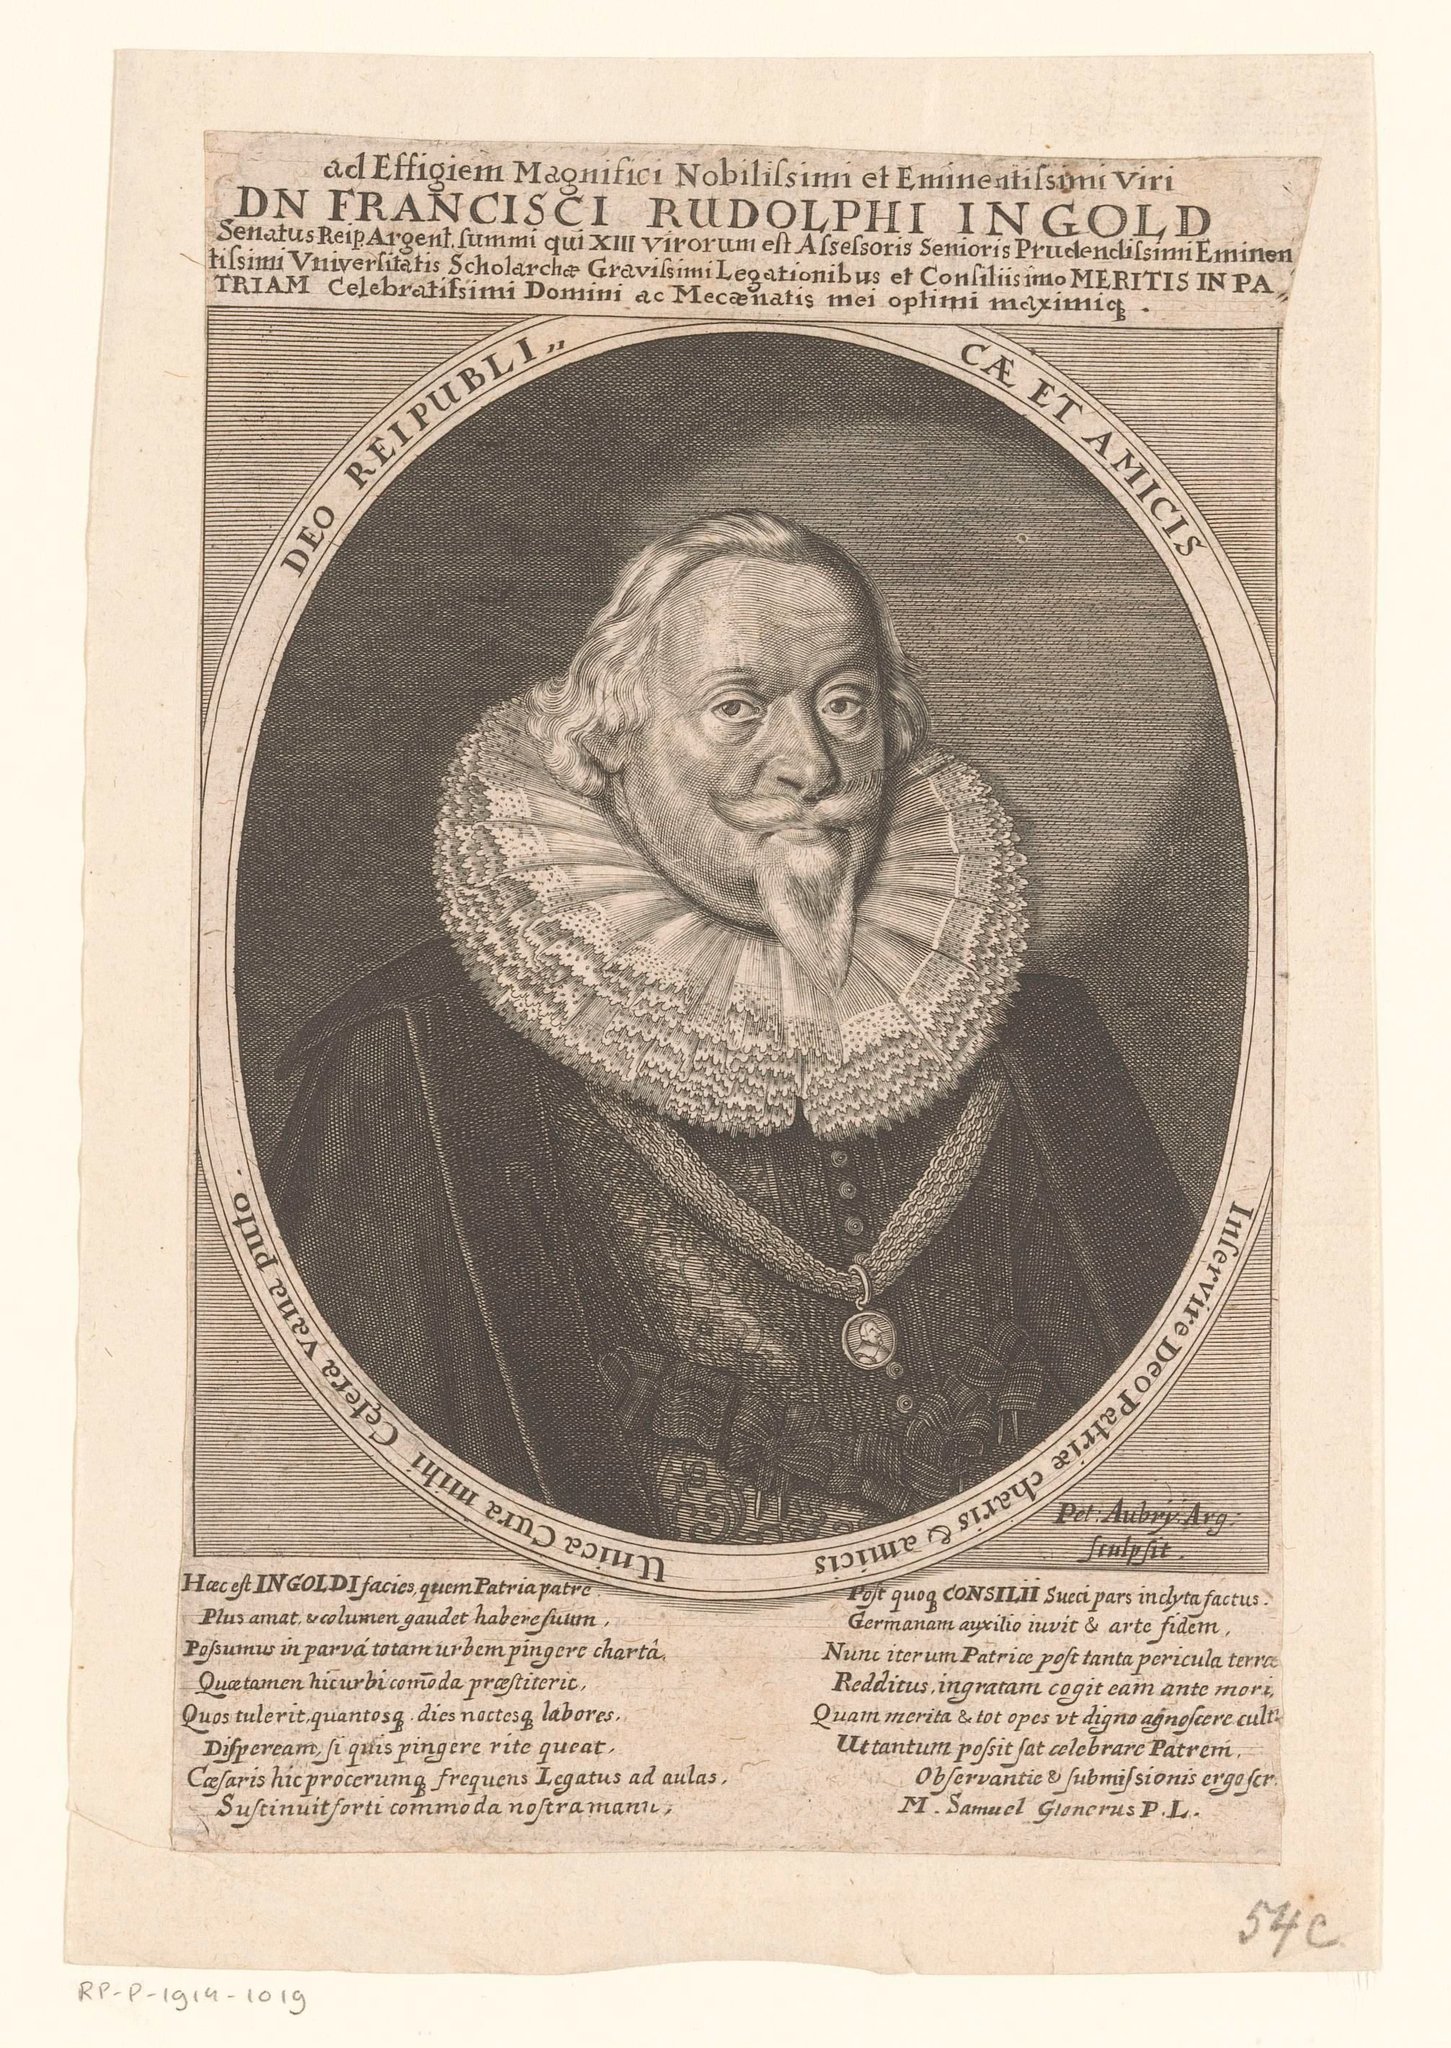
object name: book illustration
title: Portret van François-Rodolphe Ingold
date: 1662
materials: paper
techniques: engraving, letterpress printing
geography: straatsburg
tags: historical persons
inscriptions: collector's mark: Lugt 2228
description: Prent afkomstig uit: [Boeckler, Johann Heinrich]. Laudatio Posthuma, Qua Illustris Viri, Francisci Rudolphi Ingoldi, Reip. Argentoratensis Senioris (...) Memoriam publica pietate honoravit Academia, XXXI die Martii, an. MDCXLII. Straatsburg: Johann Philip Mülbe, 1662.